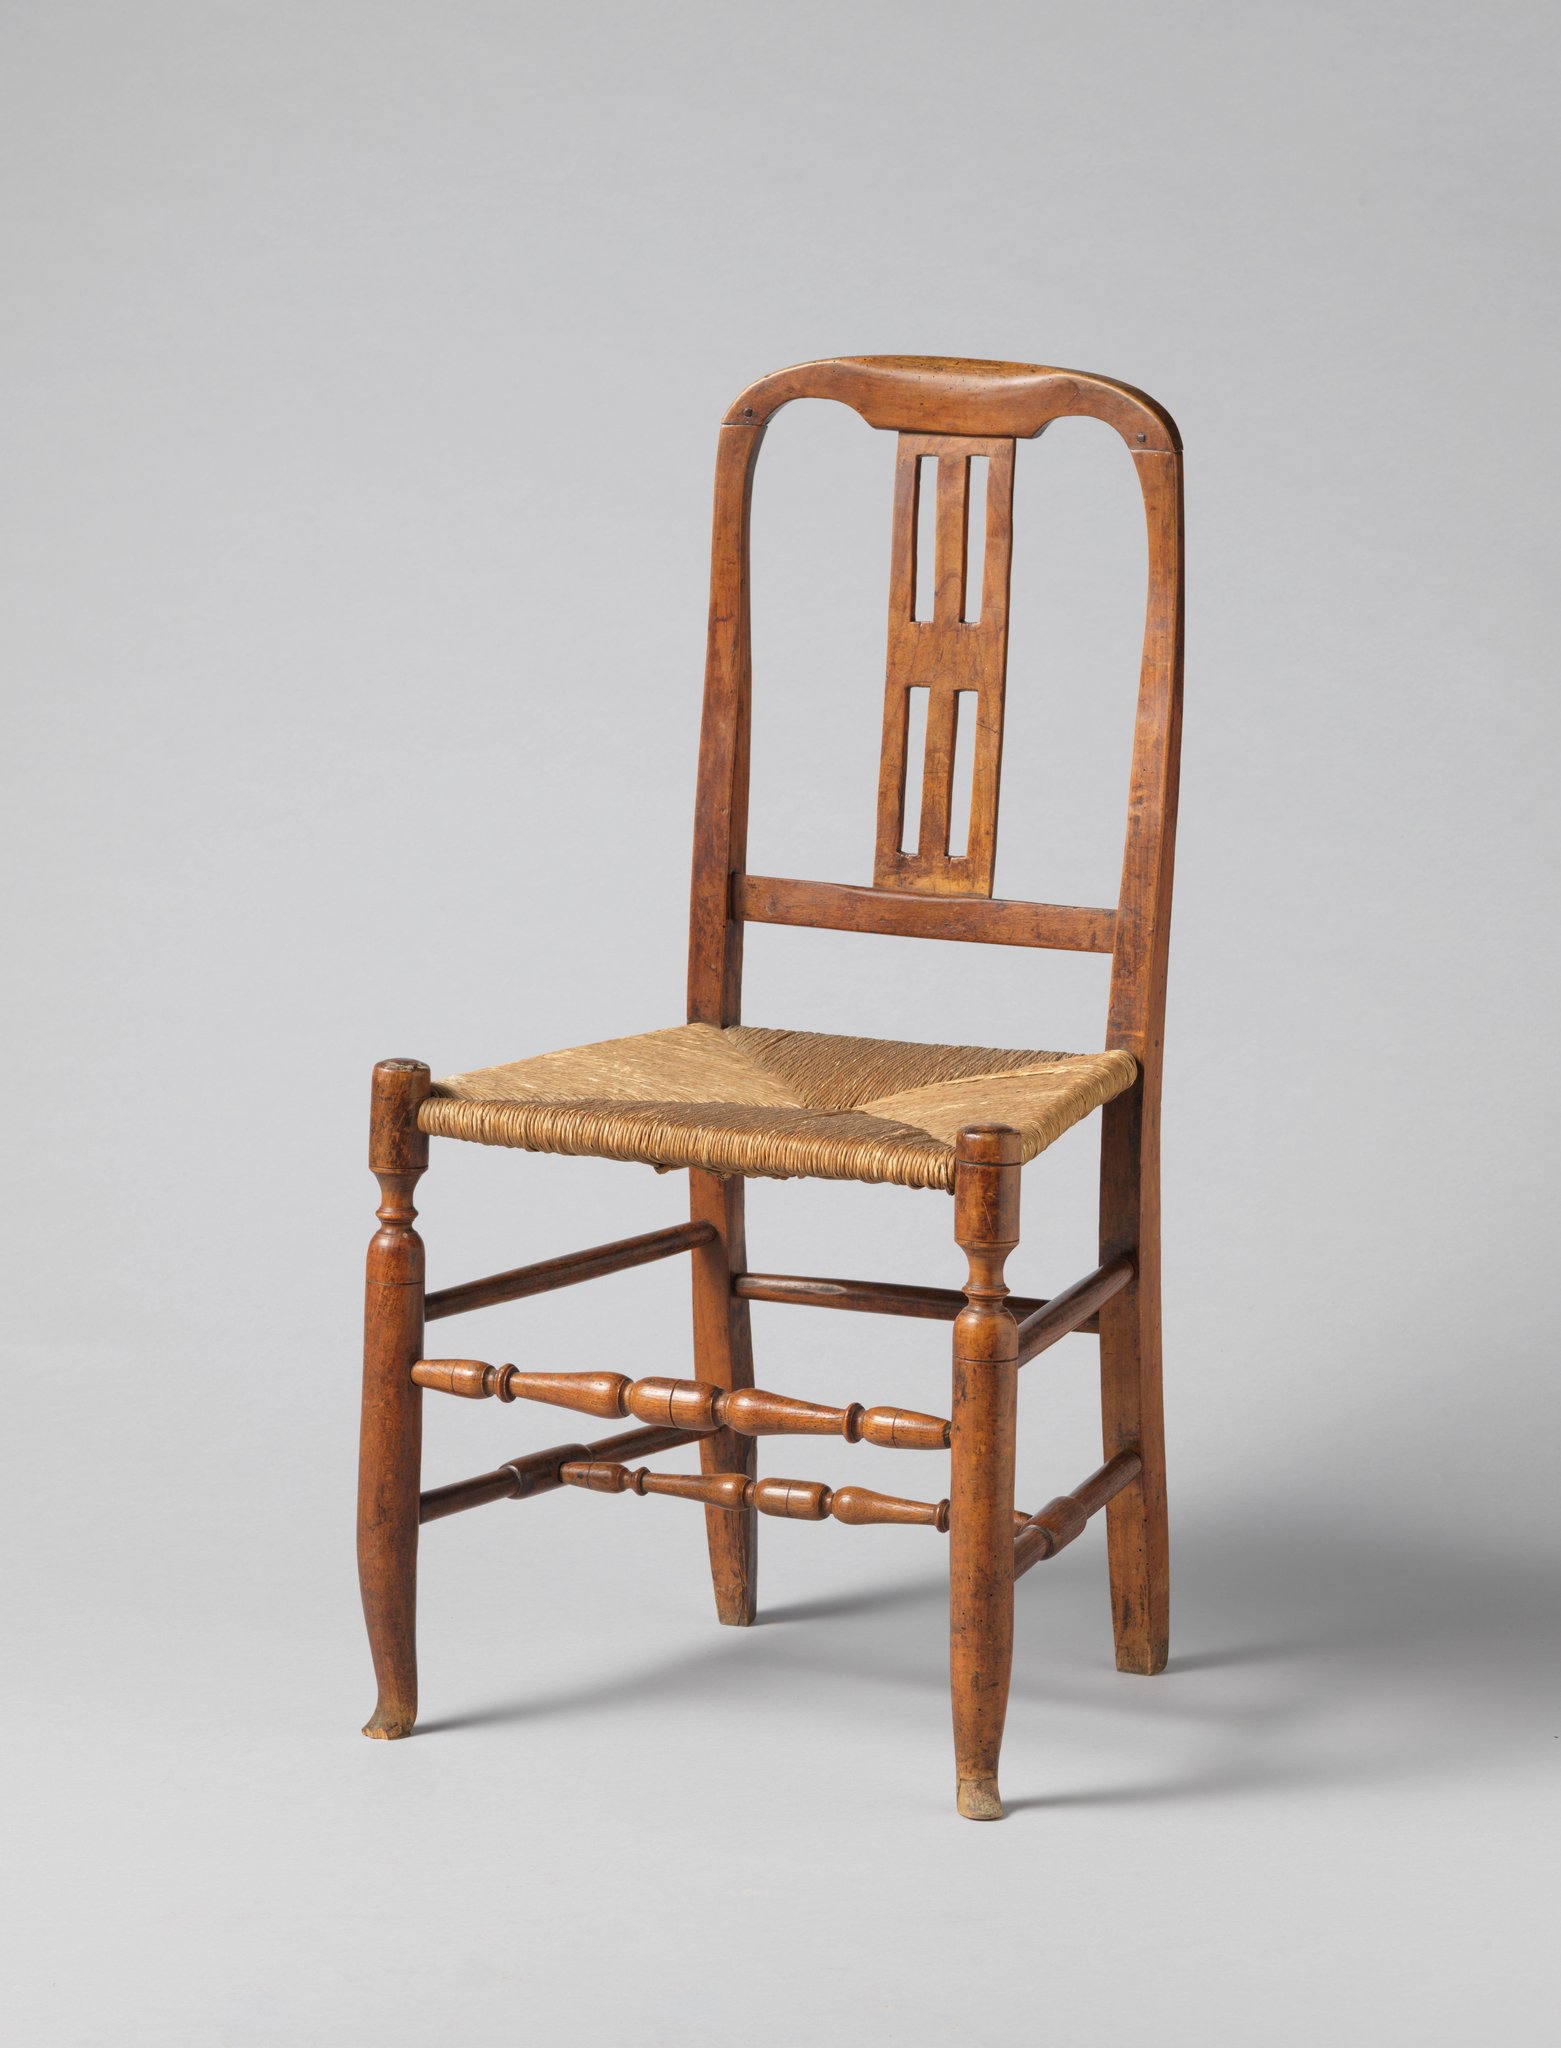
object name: furniture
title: Stoel met matten zitting, licht geholde rug en gebogen bovendorpel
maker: Anonymous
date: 1785-1800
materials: wood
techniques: caning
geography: northern netherlands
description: Stoel van iepen-, beuken- en kersenhout met een matten zitting. De voorpoten, het H-vormige kruis en de vier sporten zijn gedraaid; de voorpoten hebben een ingezwikte en afgeplatte voet. De rug is licht gehold, de bovendorpel gebogen, de middenbaan is voorzien van rechthoekige doorbrekingen.